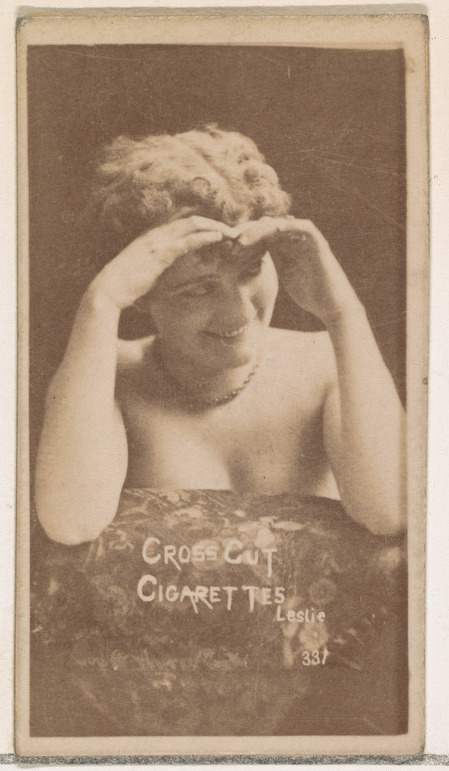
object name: print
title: Card Number 331, Leslie, from the Actors and Actresses series (N145-1) issued by Duke Sons & Co. to promote Cross Cut Cigarettes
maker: w. duke, sons & co.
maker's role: publisher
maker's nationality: american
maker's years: 1870-1920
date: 1880-1889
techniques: albumen silver print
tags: portraits,women,actresses